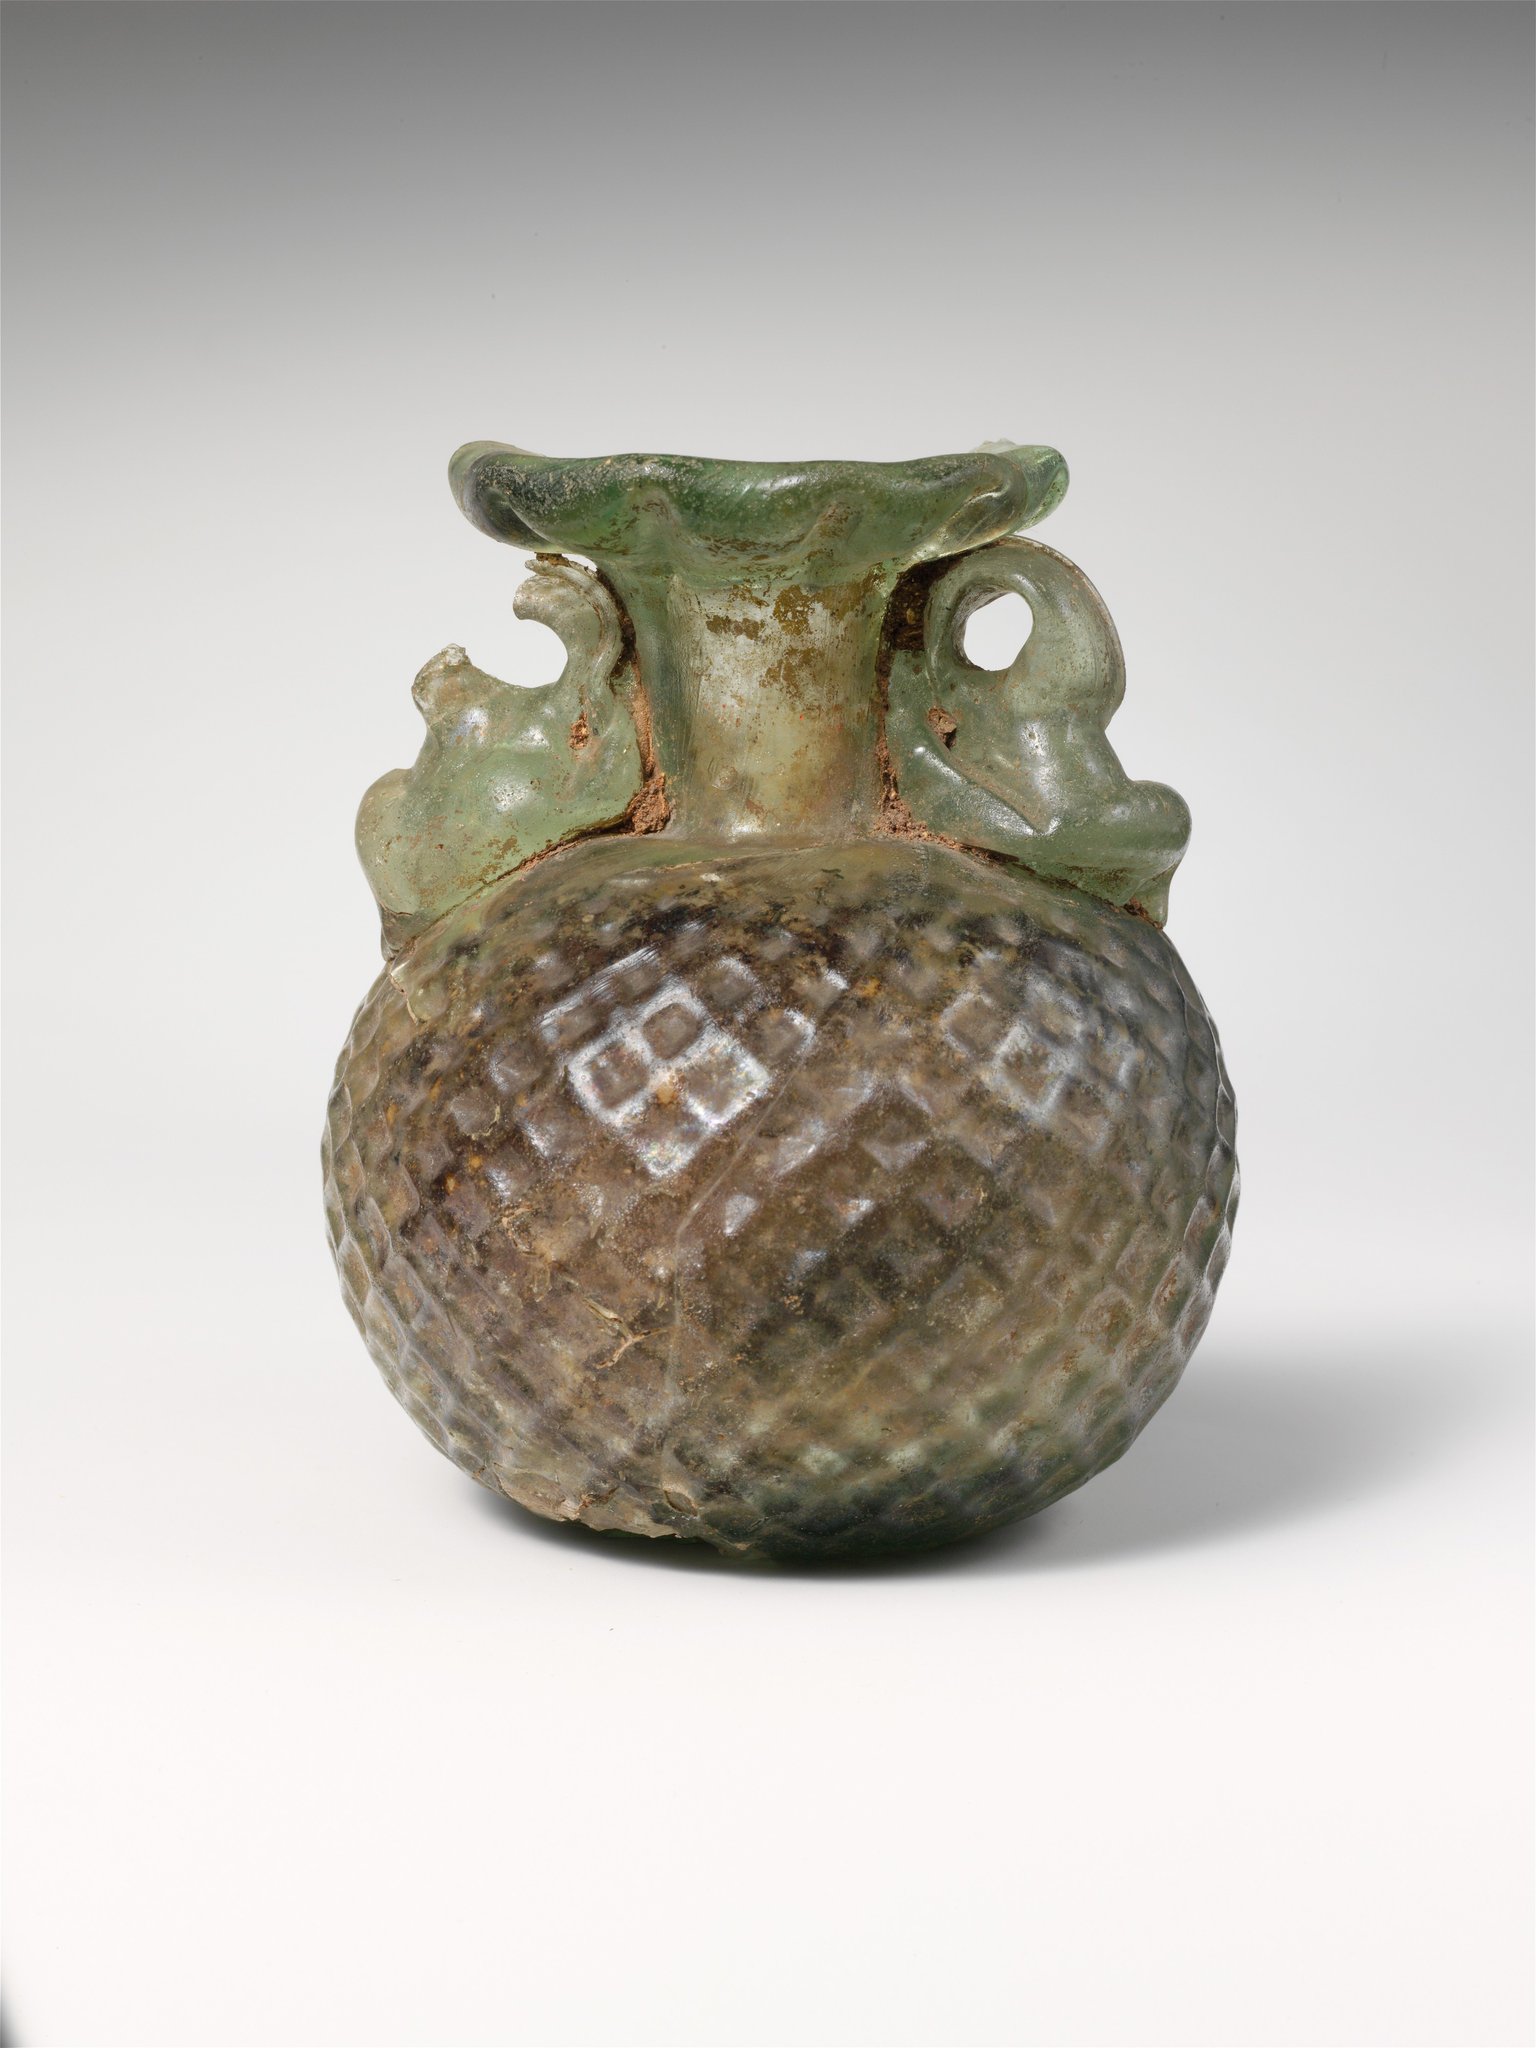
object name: oil bottle aryballos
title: Glass aryballos (oil bottle)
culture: roman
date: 201-300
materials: glass